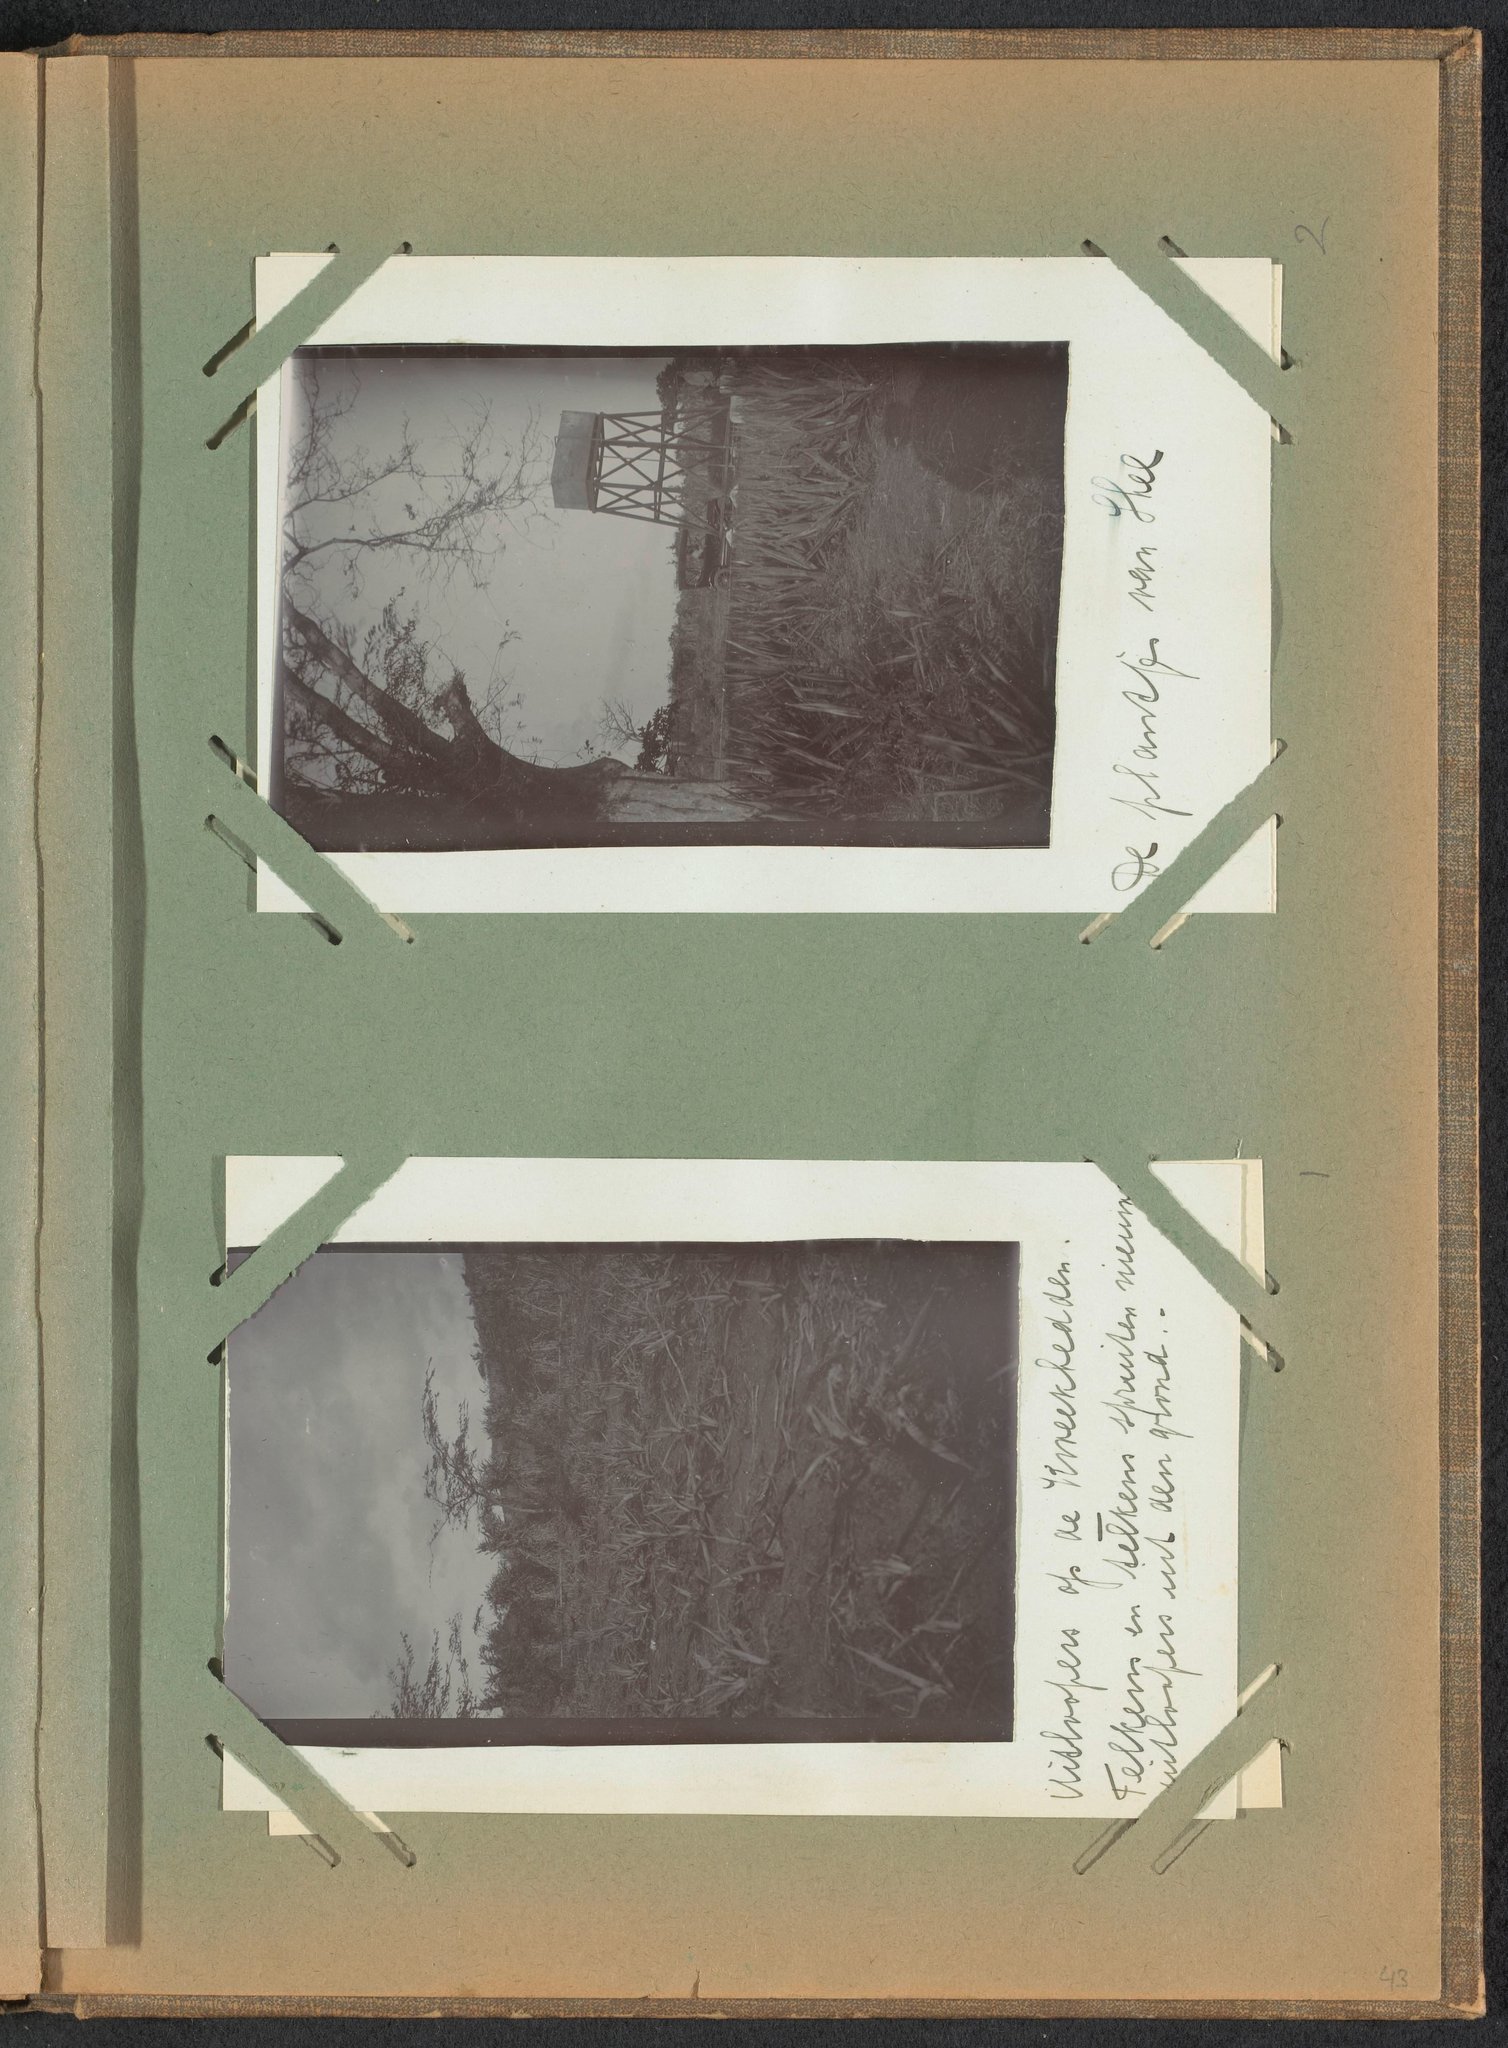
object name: photograph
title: Sisalplanten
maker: Anonymous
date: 1912-1913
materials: paper, photographic support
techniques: gelatin silver print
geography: curacao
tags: plantation, (non-fruit) products of plants or trees: sisal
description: Sisalplanten op Plantage Mount Pleasant op Curaçao. Onderdeel van het fotoalbum uit ca. 1912-1913 met 92 foto's van de plantages Peperpot en Dordrecht in Suriname en Mount Pleasant op Curaçao.